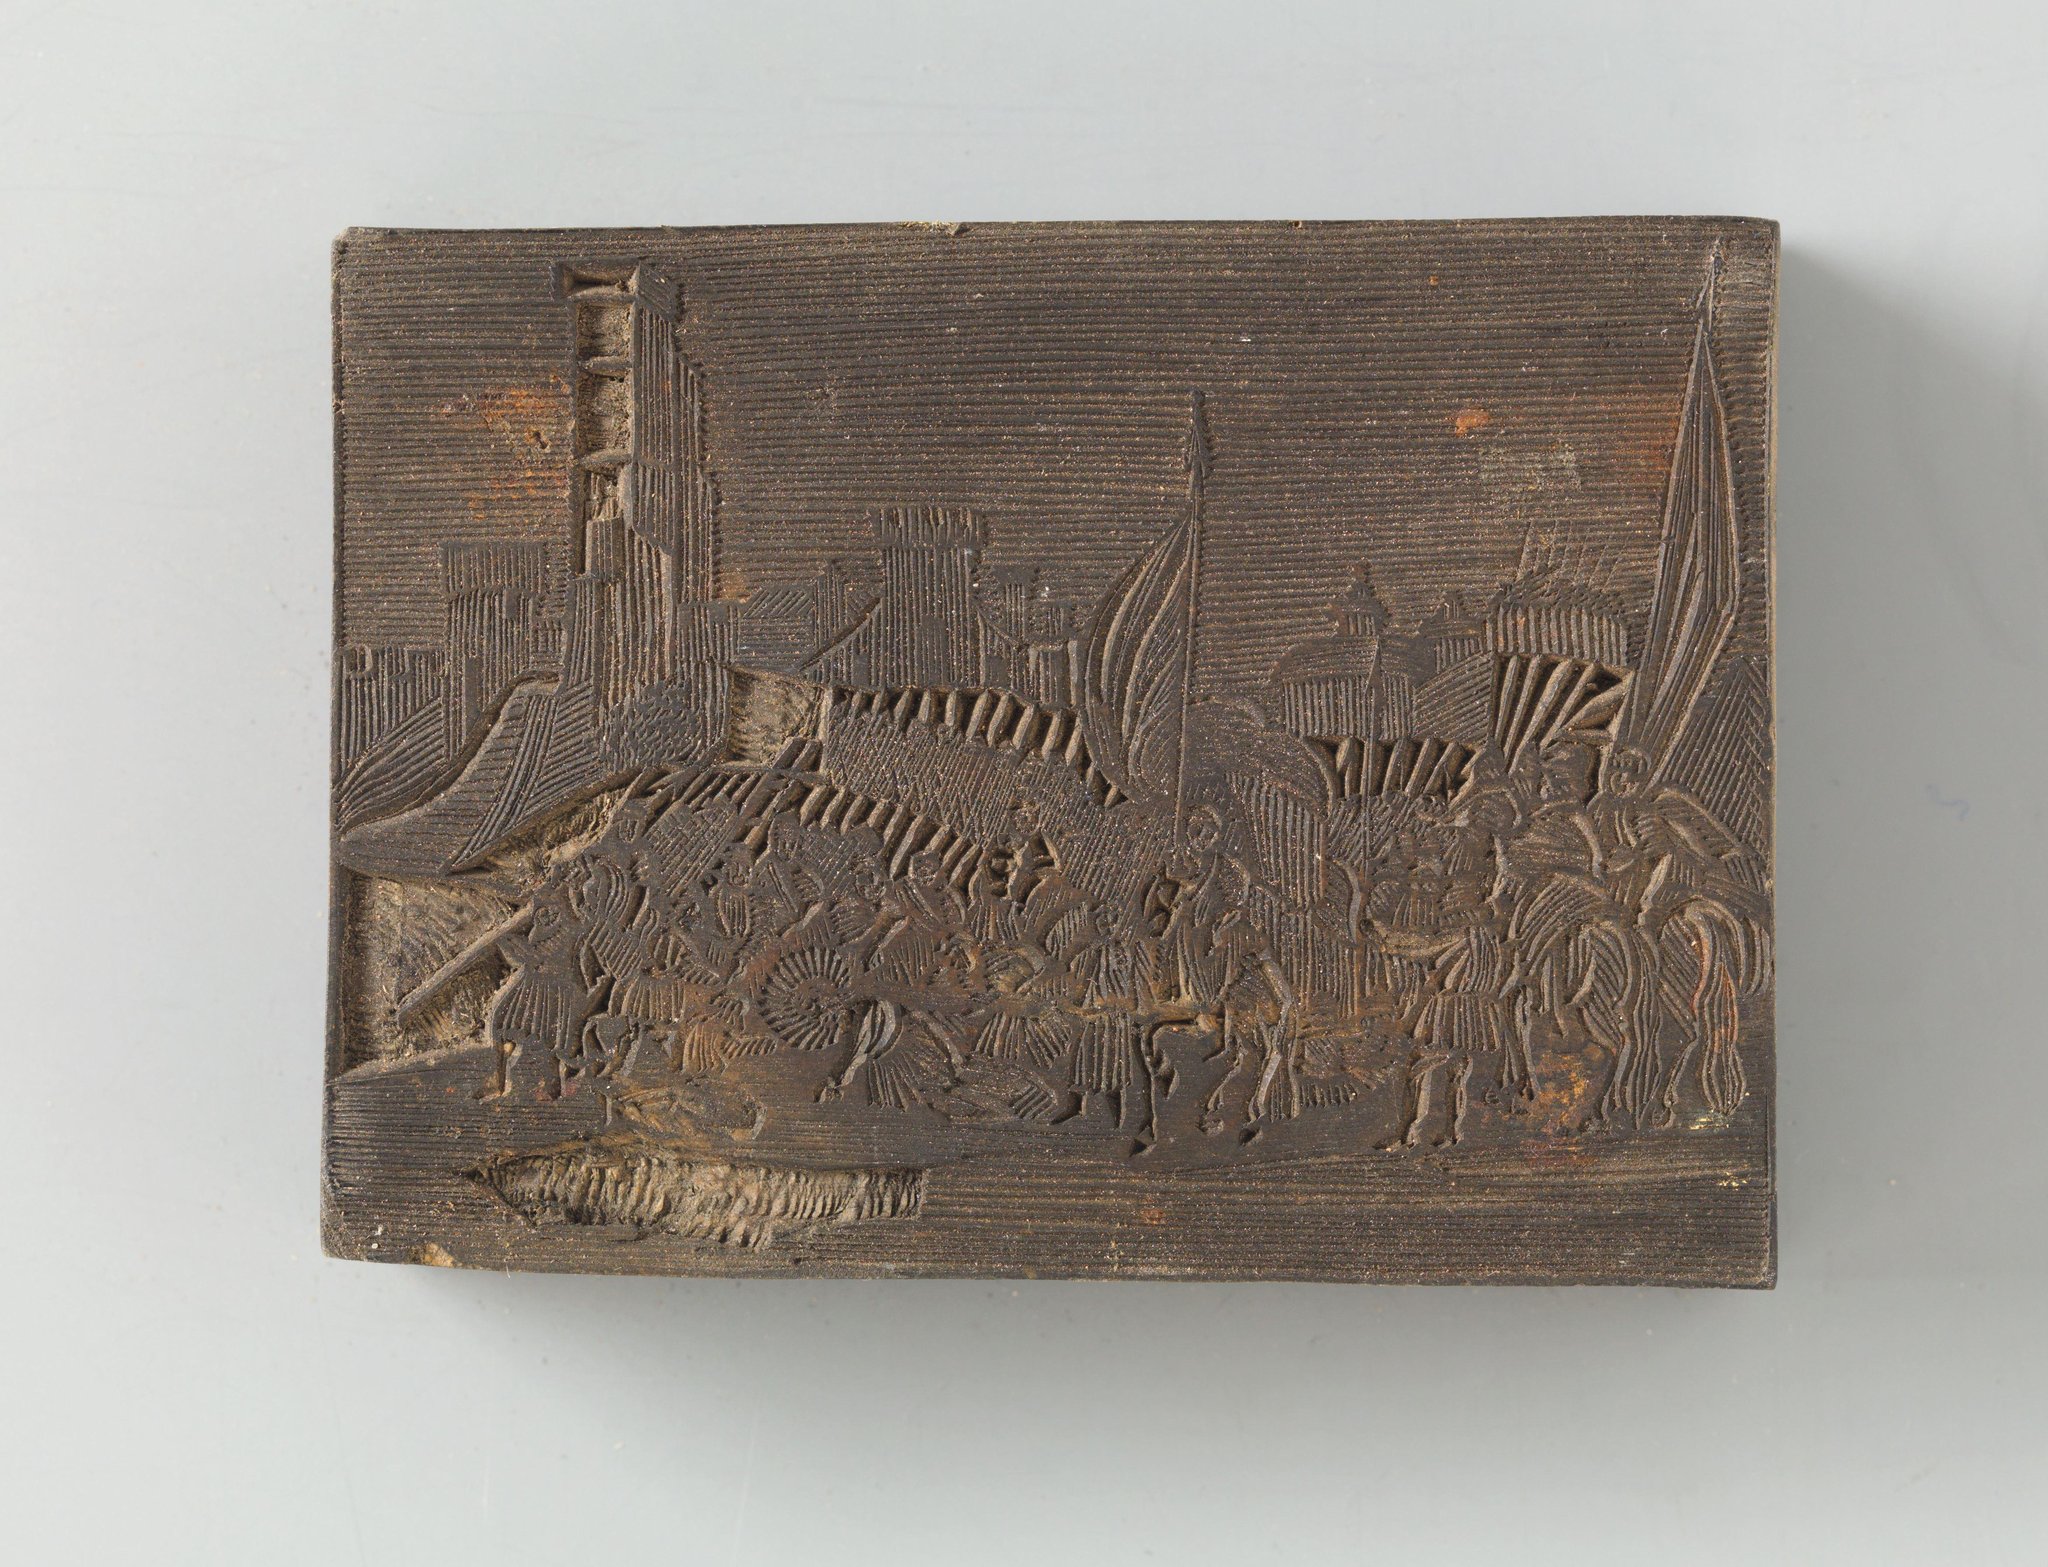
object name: wood block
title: Bijbel-illustraties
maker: Anonymous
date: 1550-1699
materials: wood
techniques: woodcut